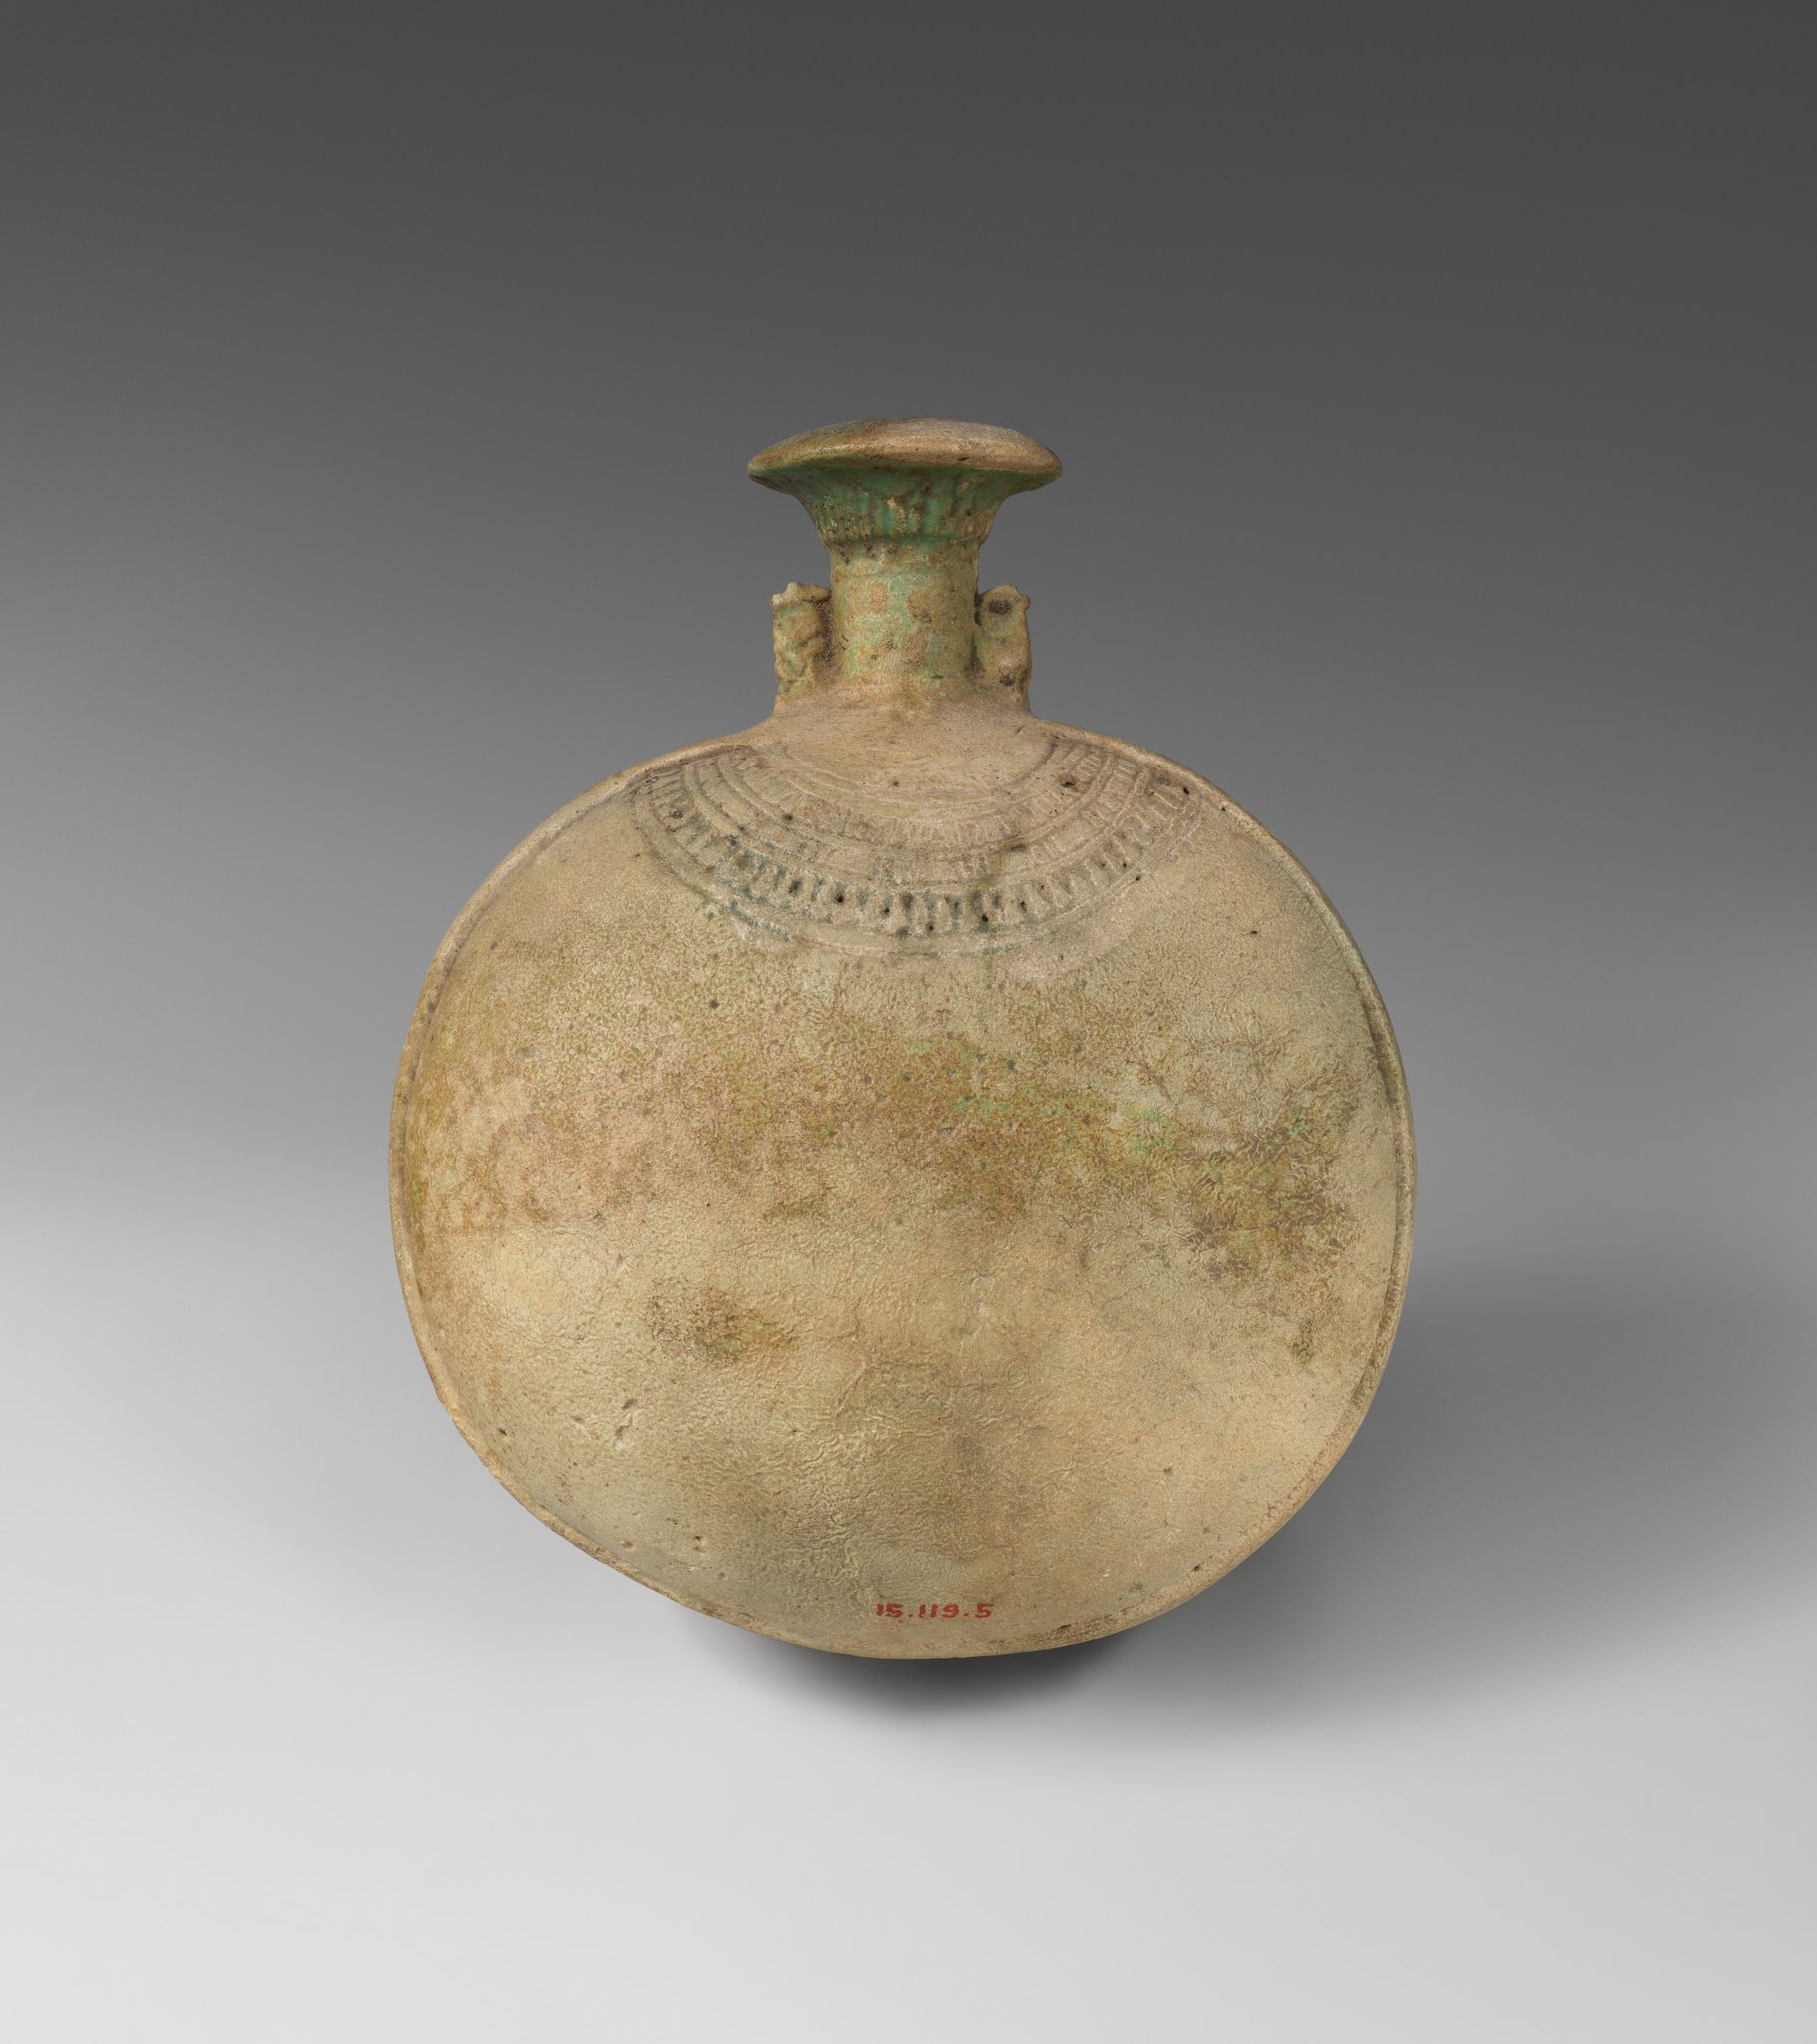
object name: lentoid bottle, new year's bottle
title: Lentoid Bottle ("New Year's Bottle")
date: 664-332 BCE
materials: faience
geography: egypt